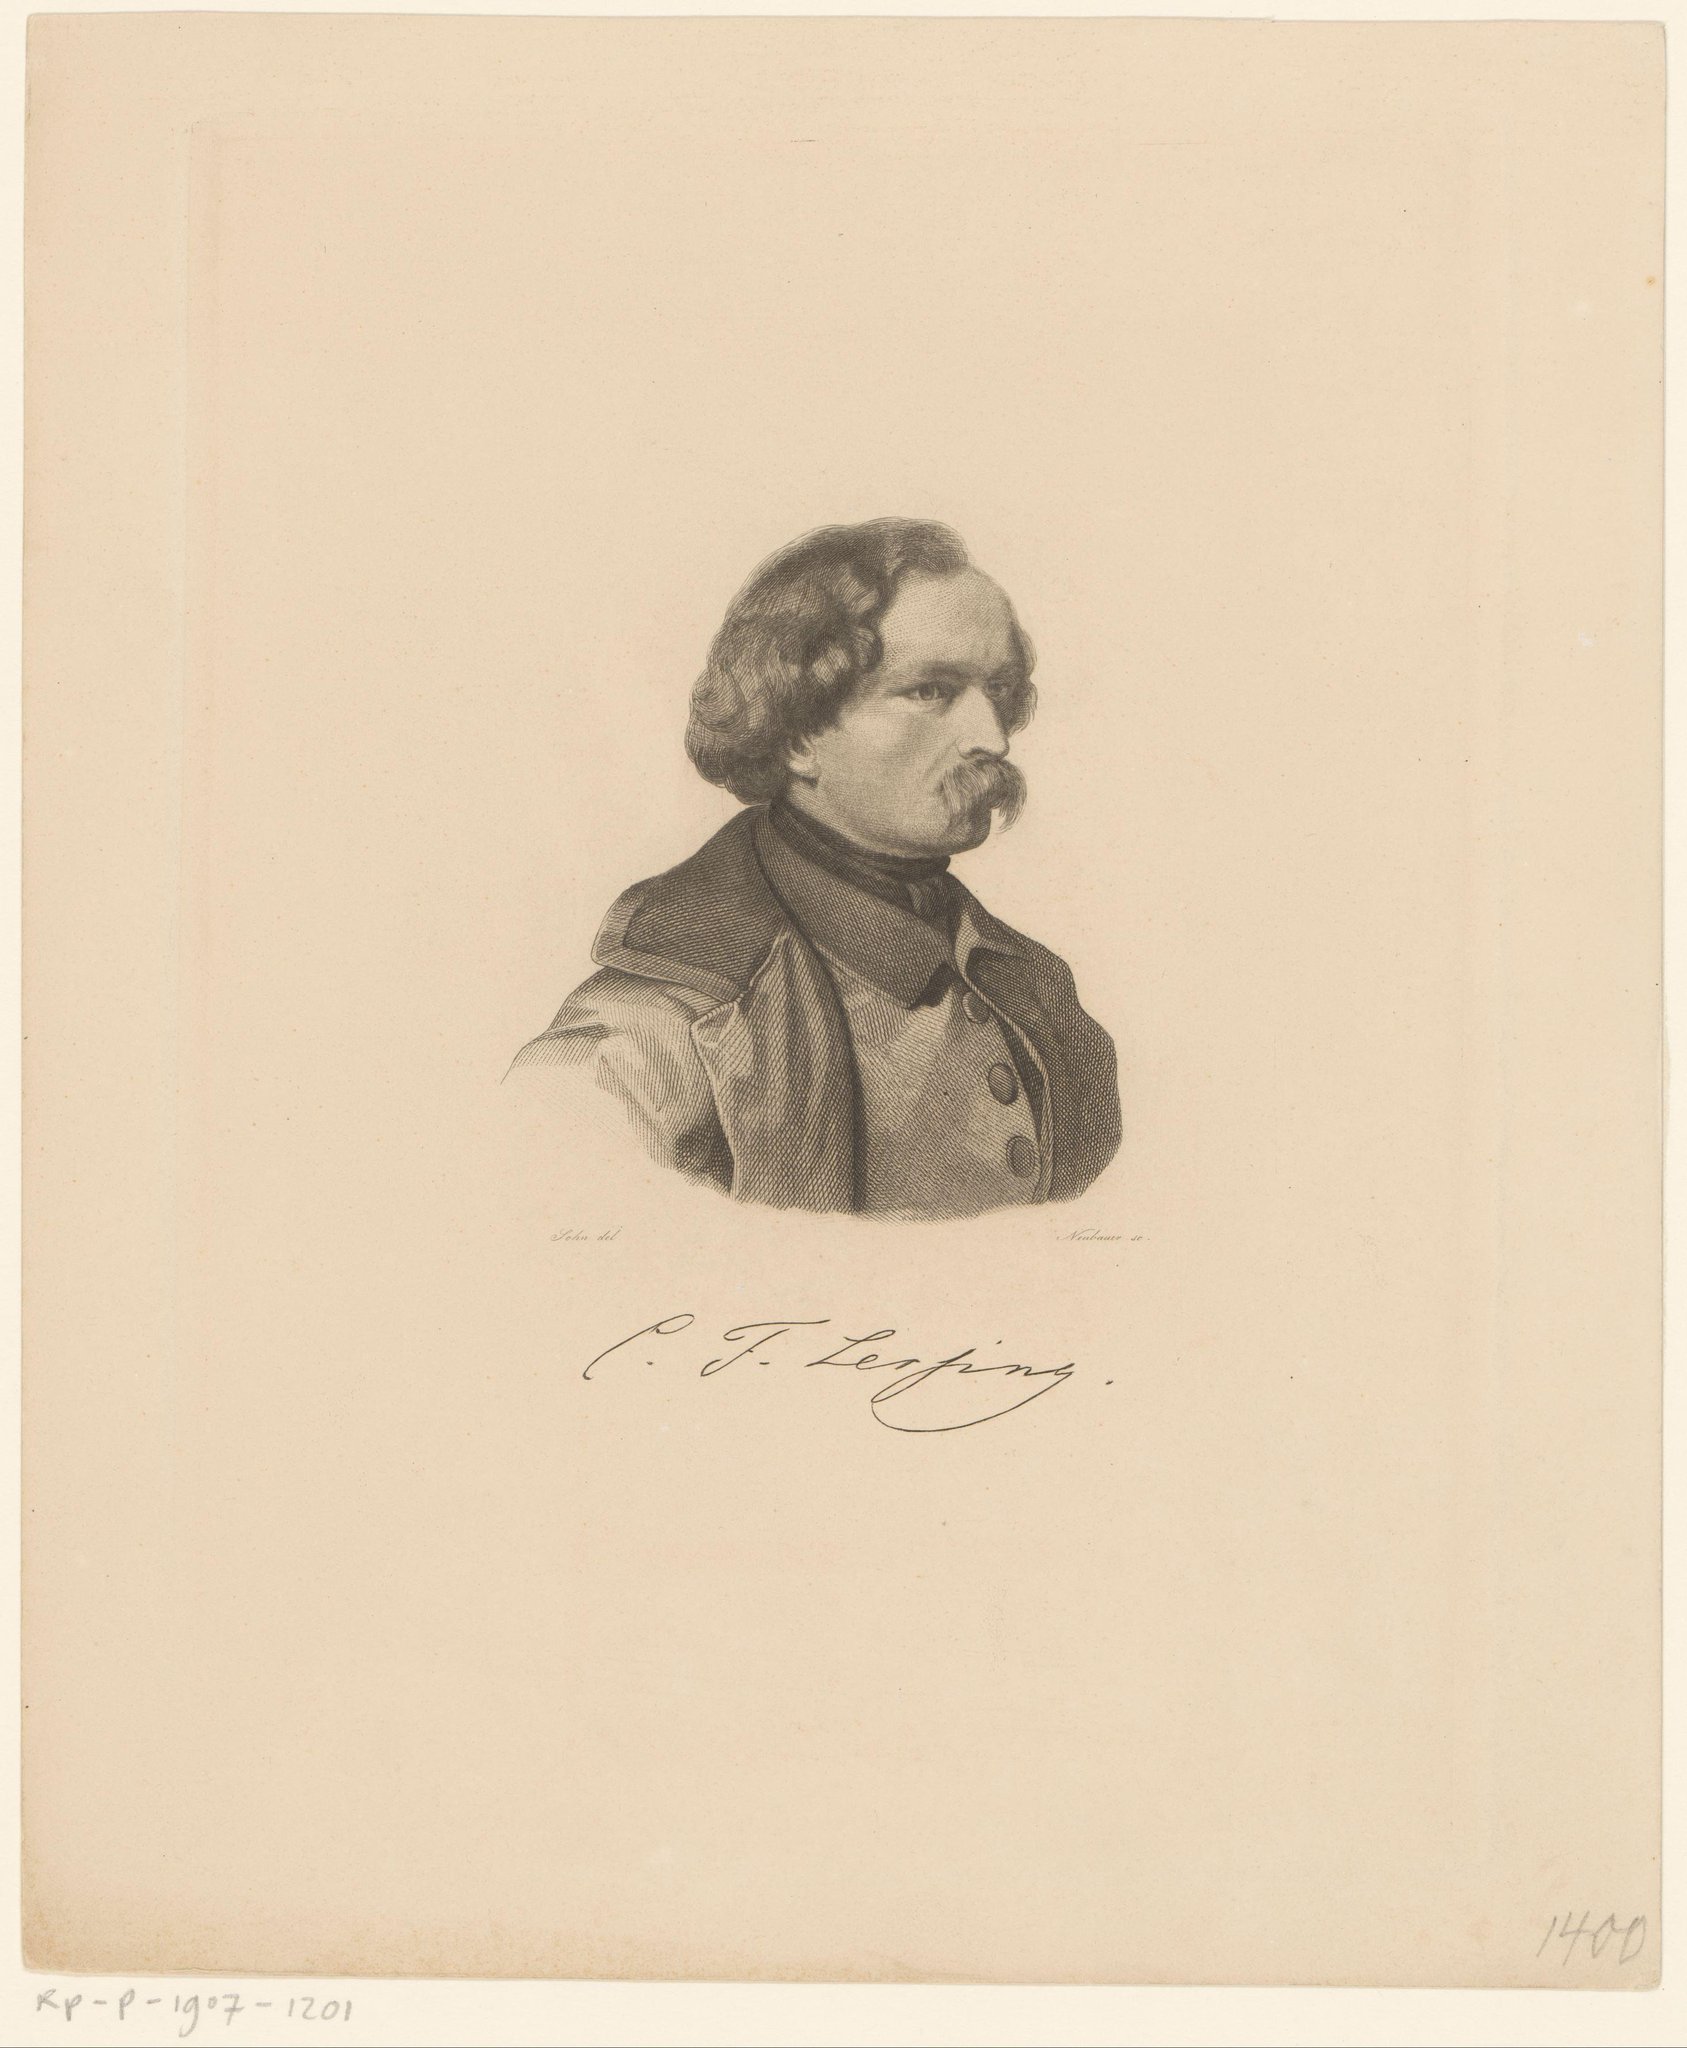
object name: print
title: Portret van Carl Friedrich Lessing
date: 1835-1882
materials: paper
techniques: etching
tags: painter, draughtsman, carl friedrich lessing, historical persons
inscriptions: collector's mark: Lugt 2228